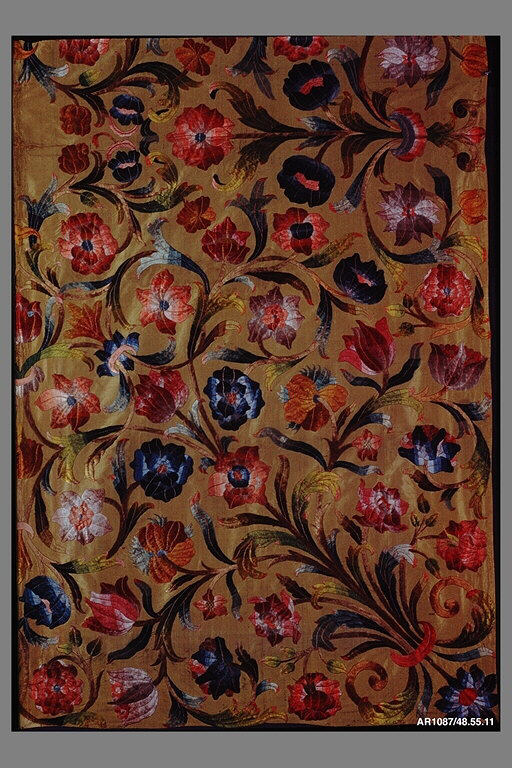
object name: cover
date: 1601-1800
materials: silk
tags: flowers